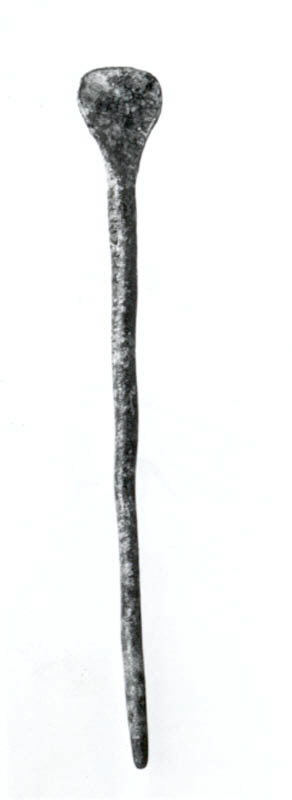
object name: pin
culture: sasanian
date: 201-700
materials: lead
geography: iran